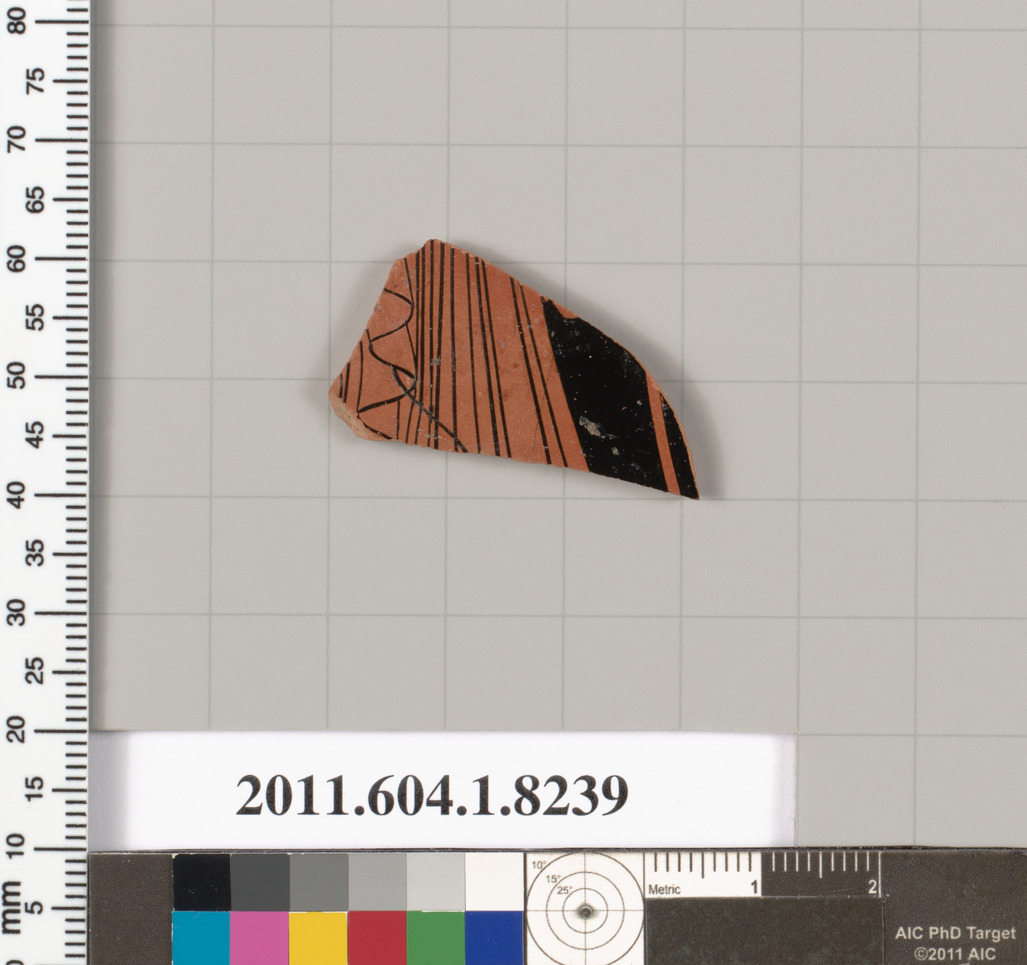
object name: kylix fragment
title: Terracotta fragment of a kylix (drinking cup)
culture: greek, attic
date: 520-510 BCE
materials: terracotta